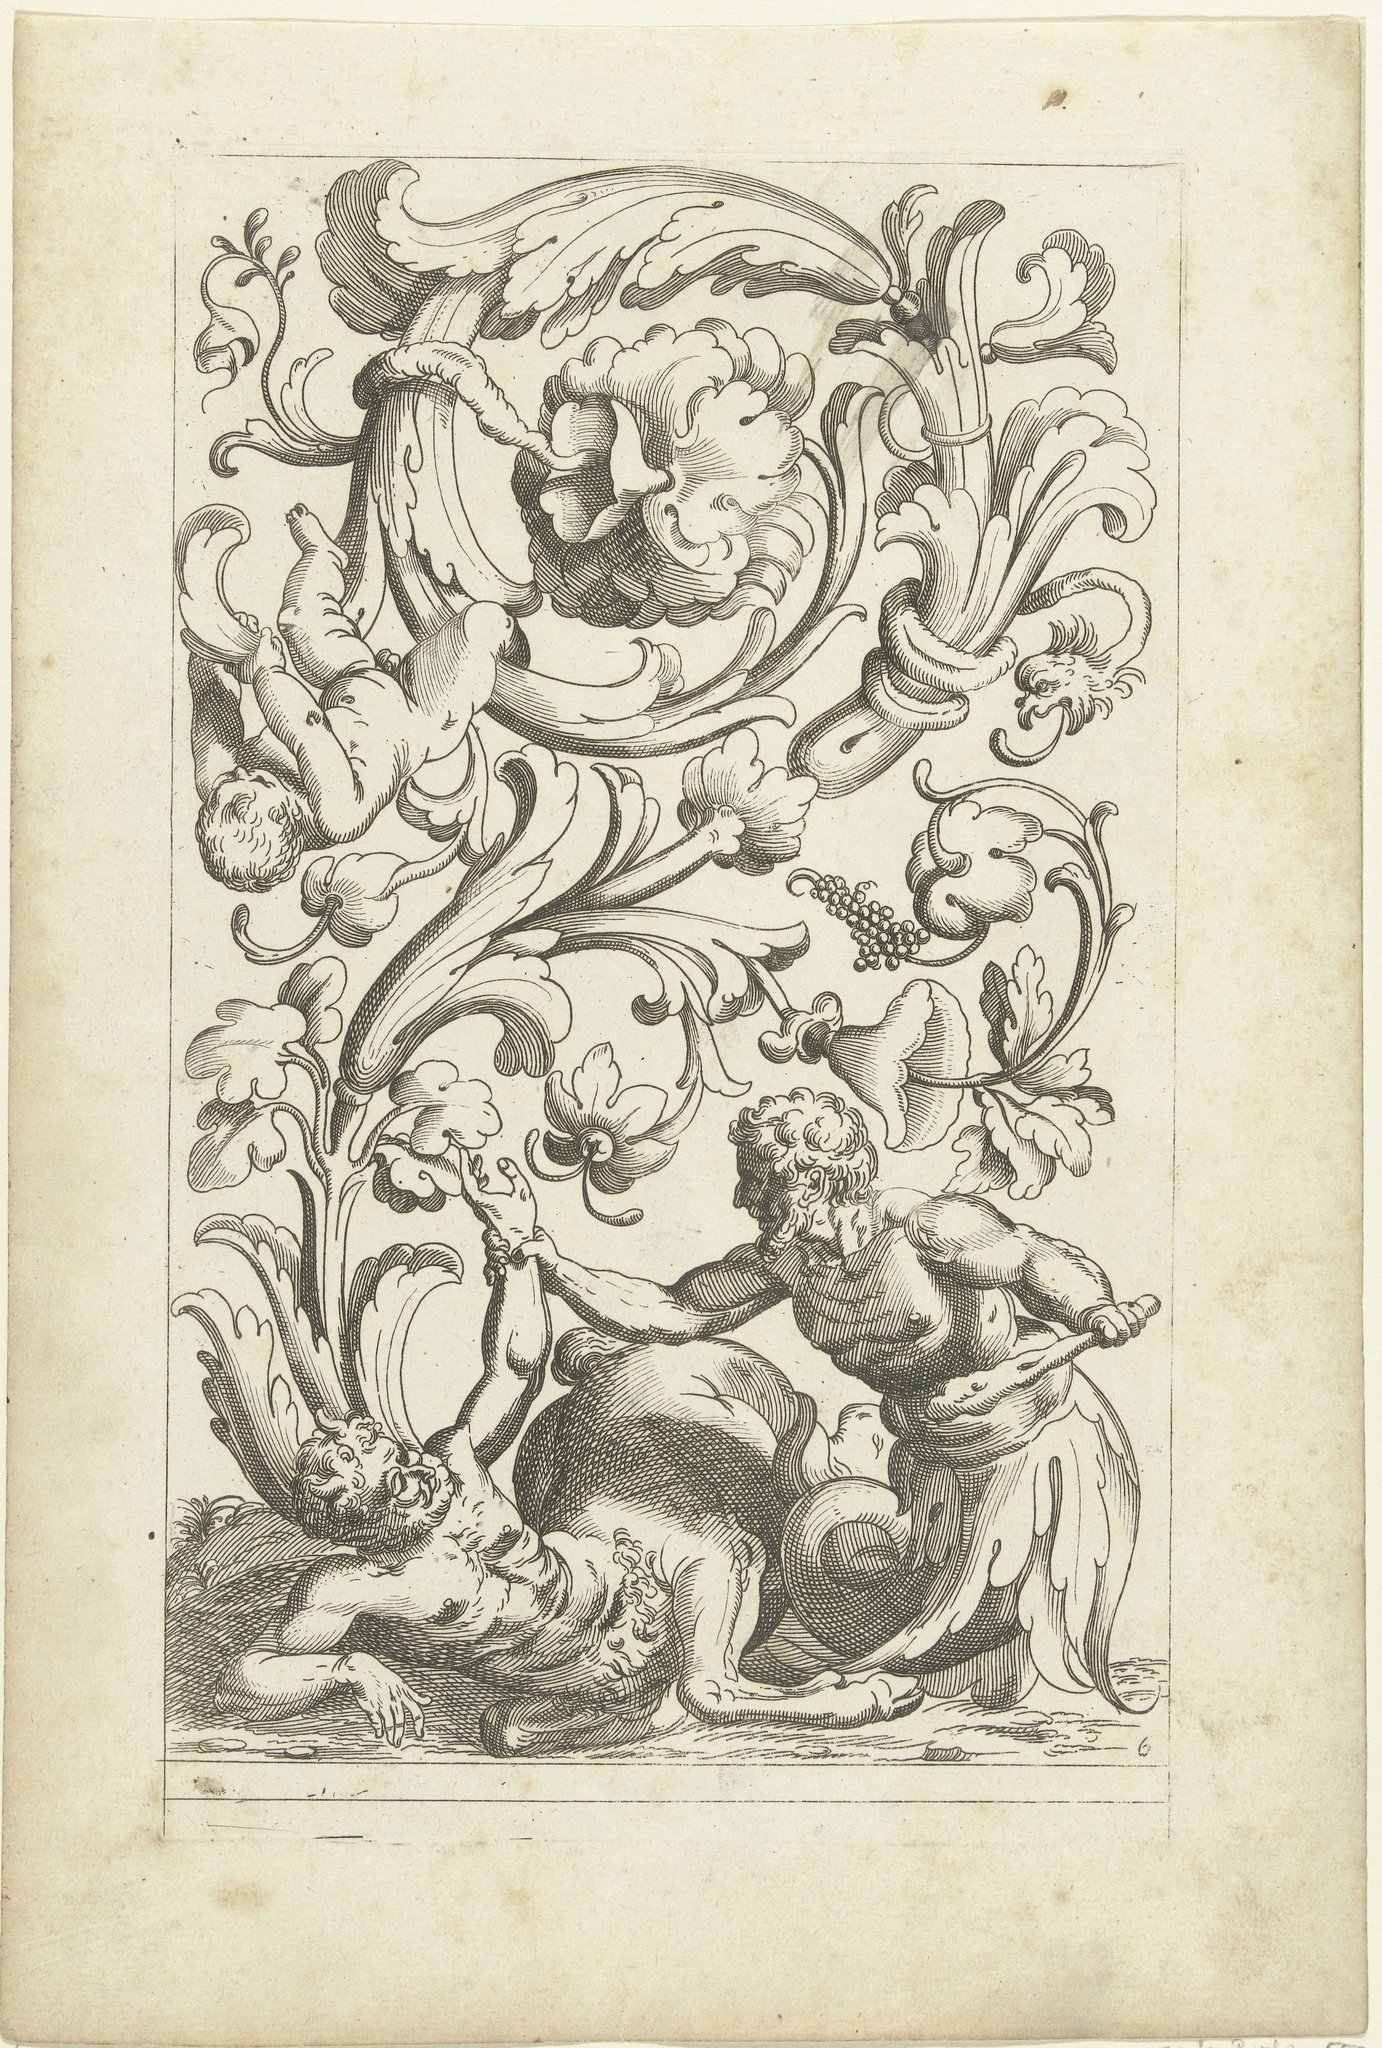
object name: ornament print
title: Disegni Varii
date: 1655-1657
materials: paper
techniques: etching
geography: italy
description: Op de achtergrond groeit een bladrank waaraan een kind hangt. Uit serie van 10 bladen met ontwerpen voor verticale panelen met bladranken, figuren en dieren.